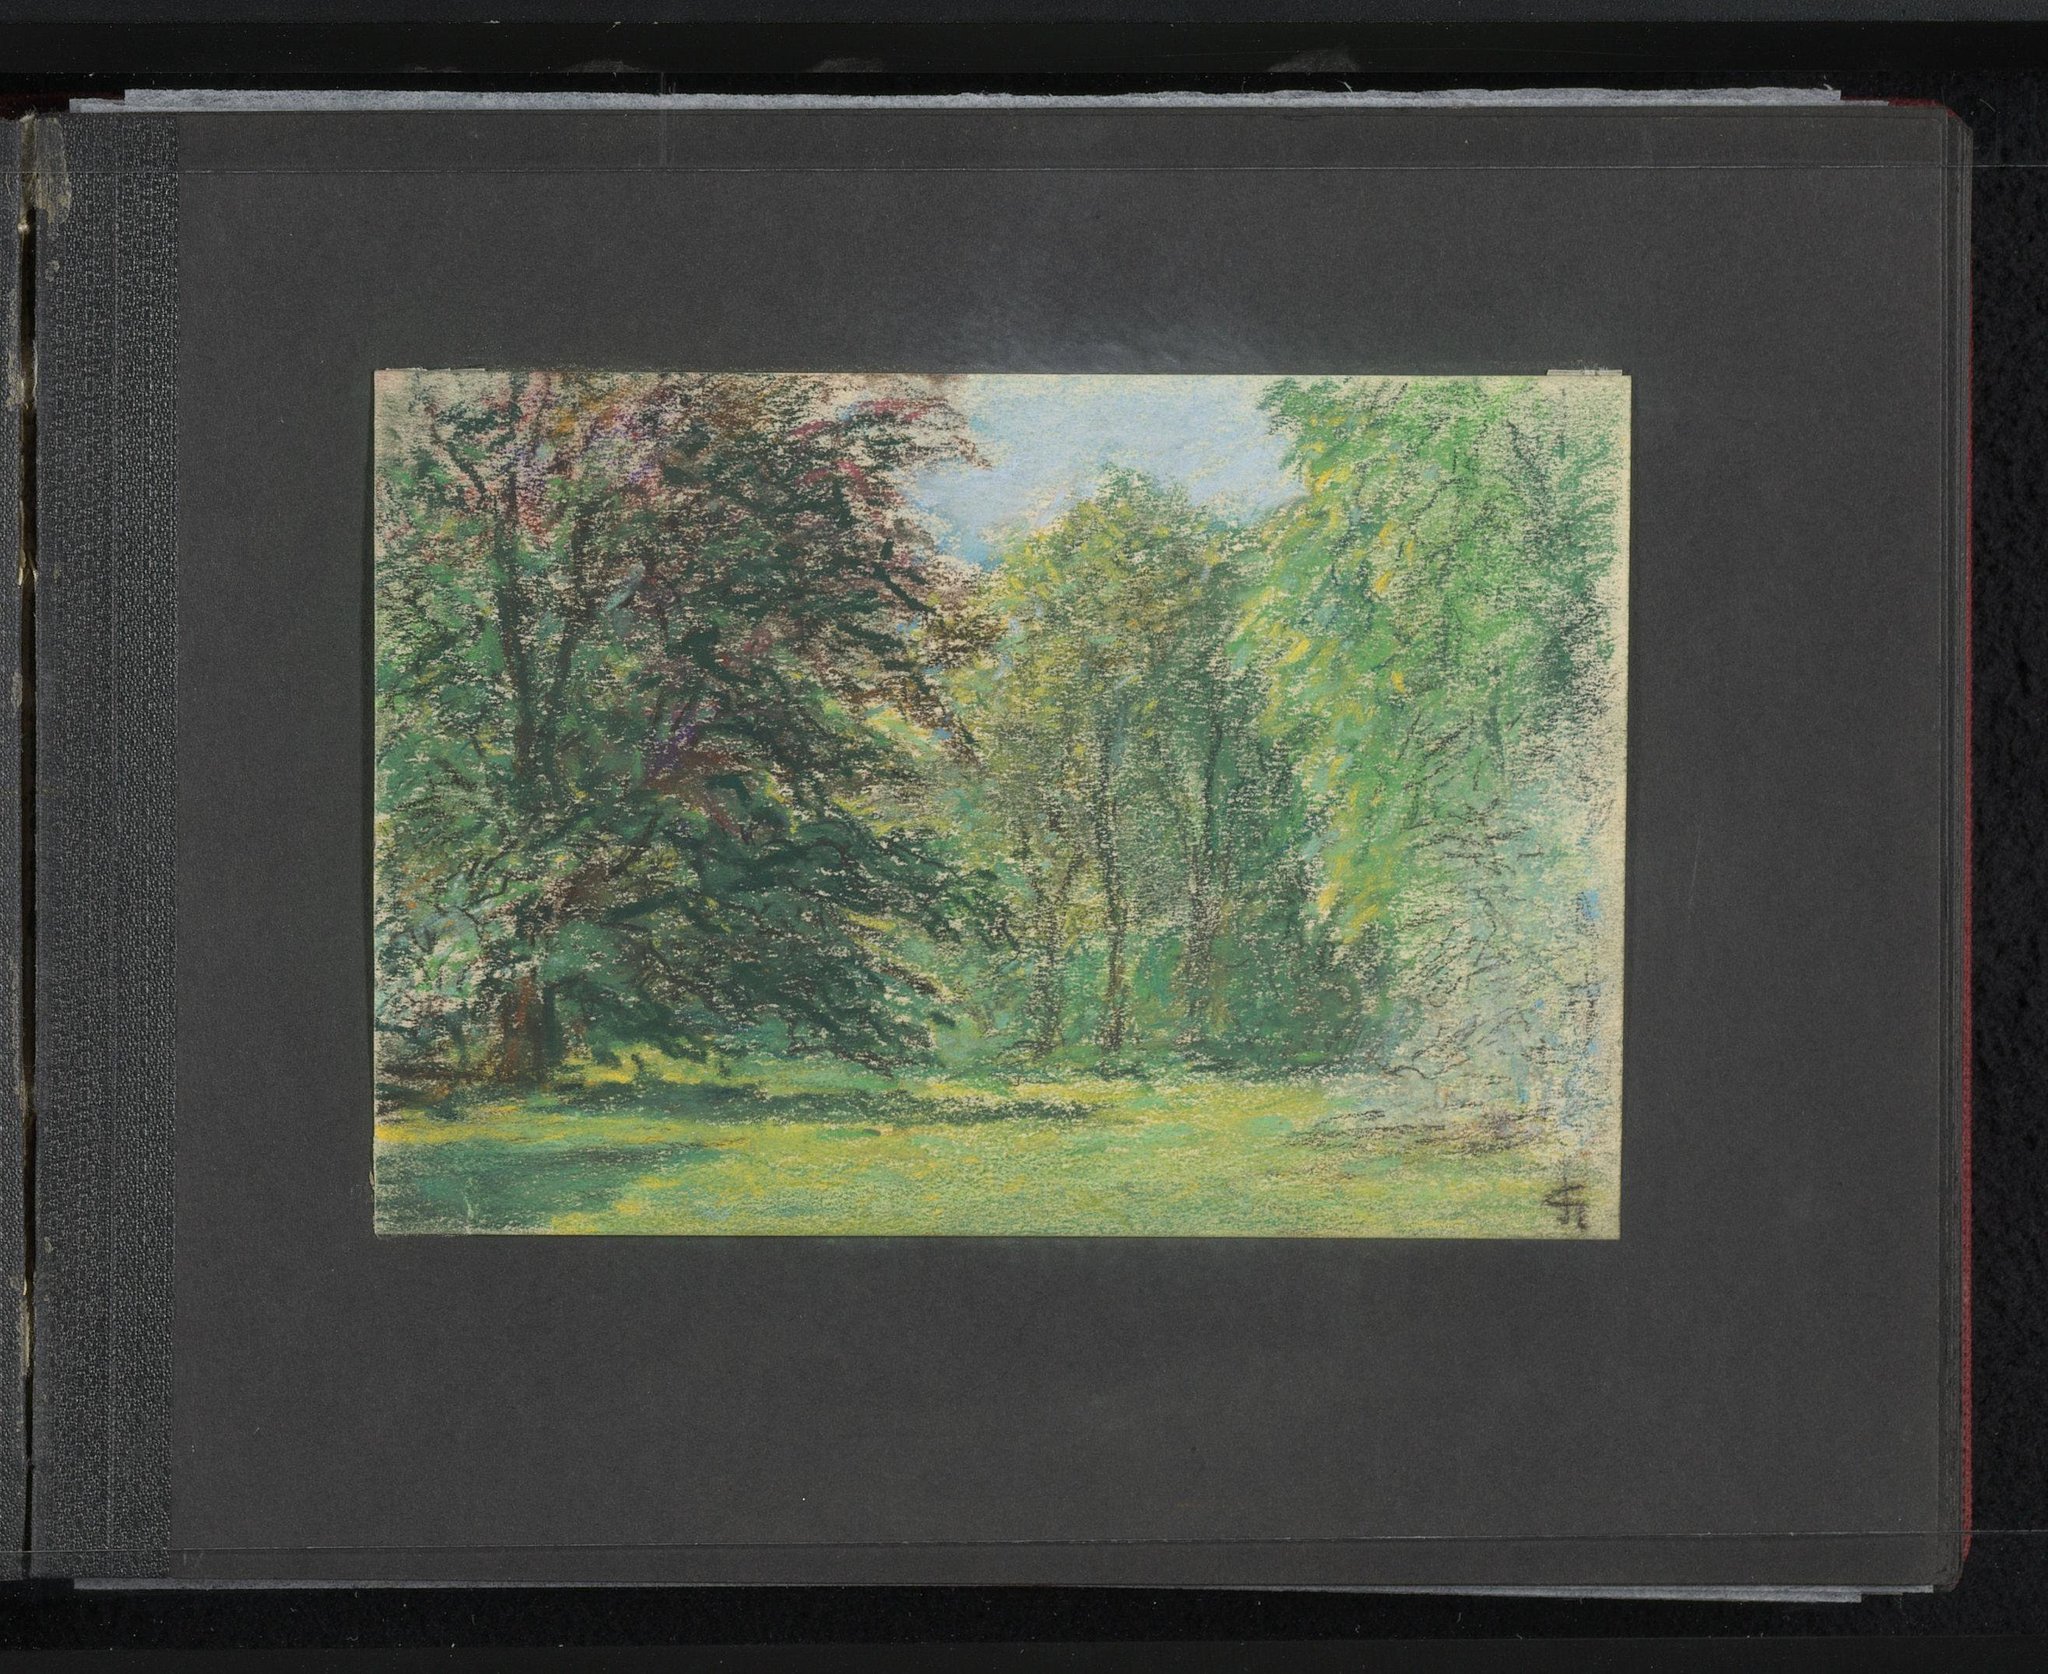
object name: album leaf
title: Bomen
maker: carel nicolaas storm van s-gravesande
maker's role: draughtsman, print maker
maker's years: 1841-1924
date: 1915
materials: chalk, paper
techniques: pasting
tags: trees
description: Mogelijk te Wiesbaden. Tekening maakt deel uit van een album.